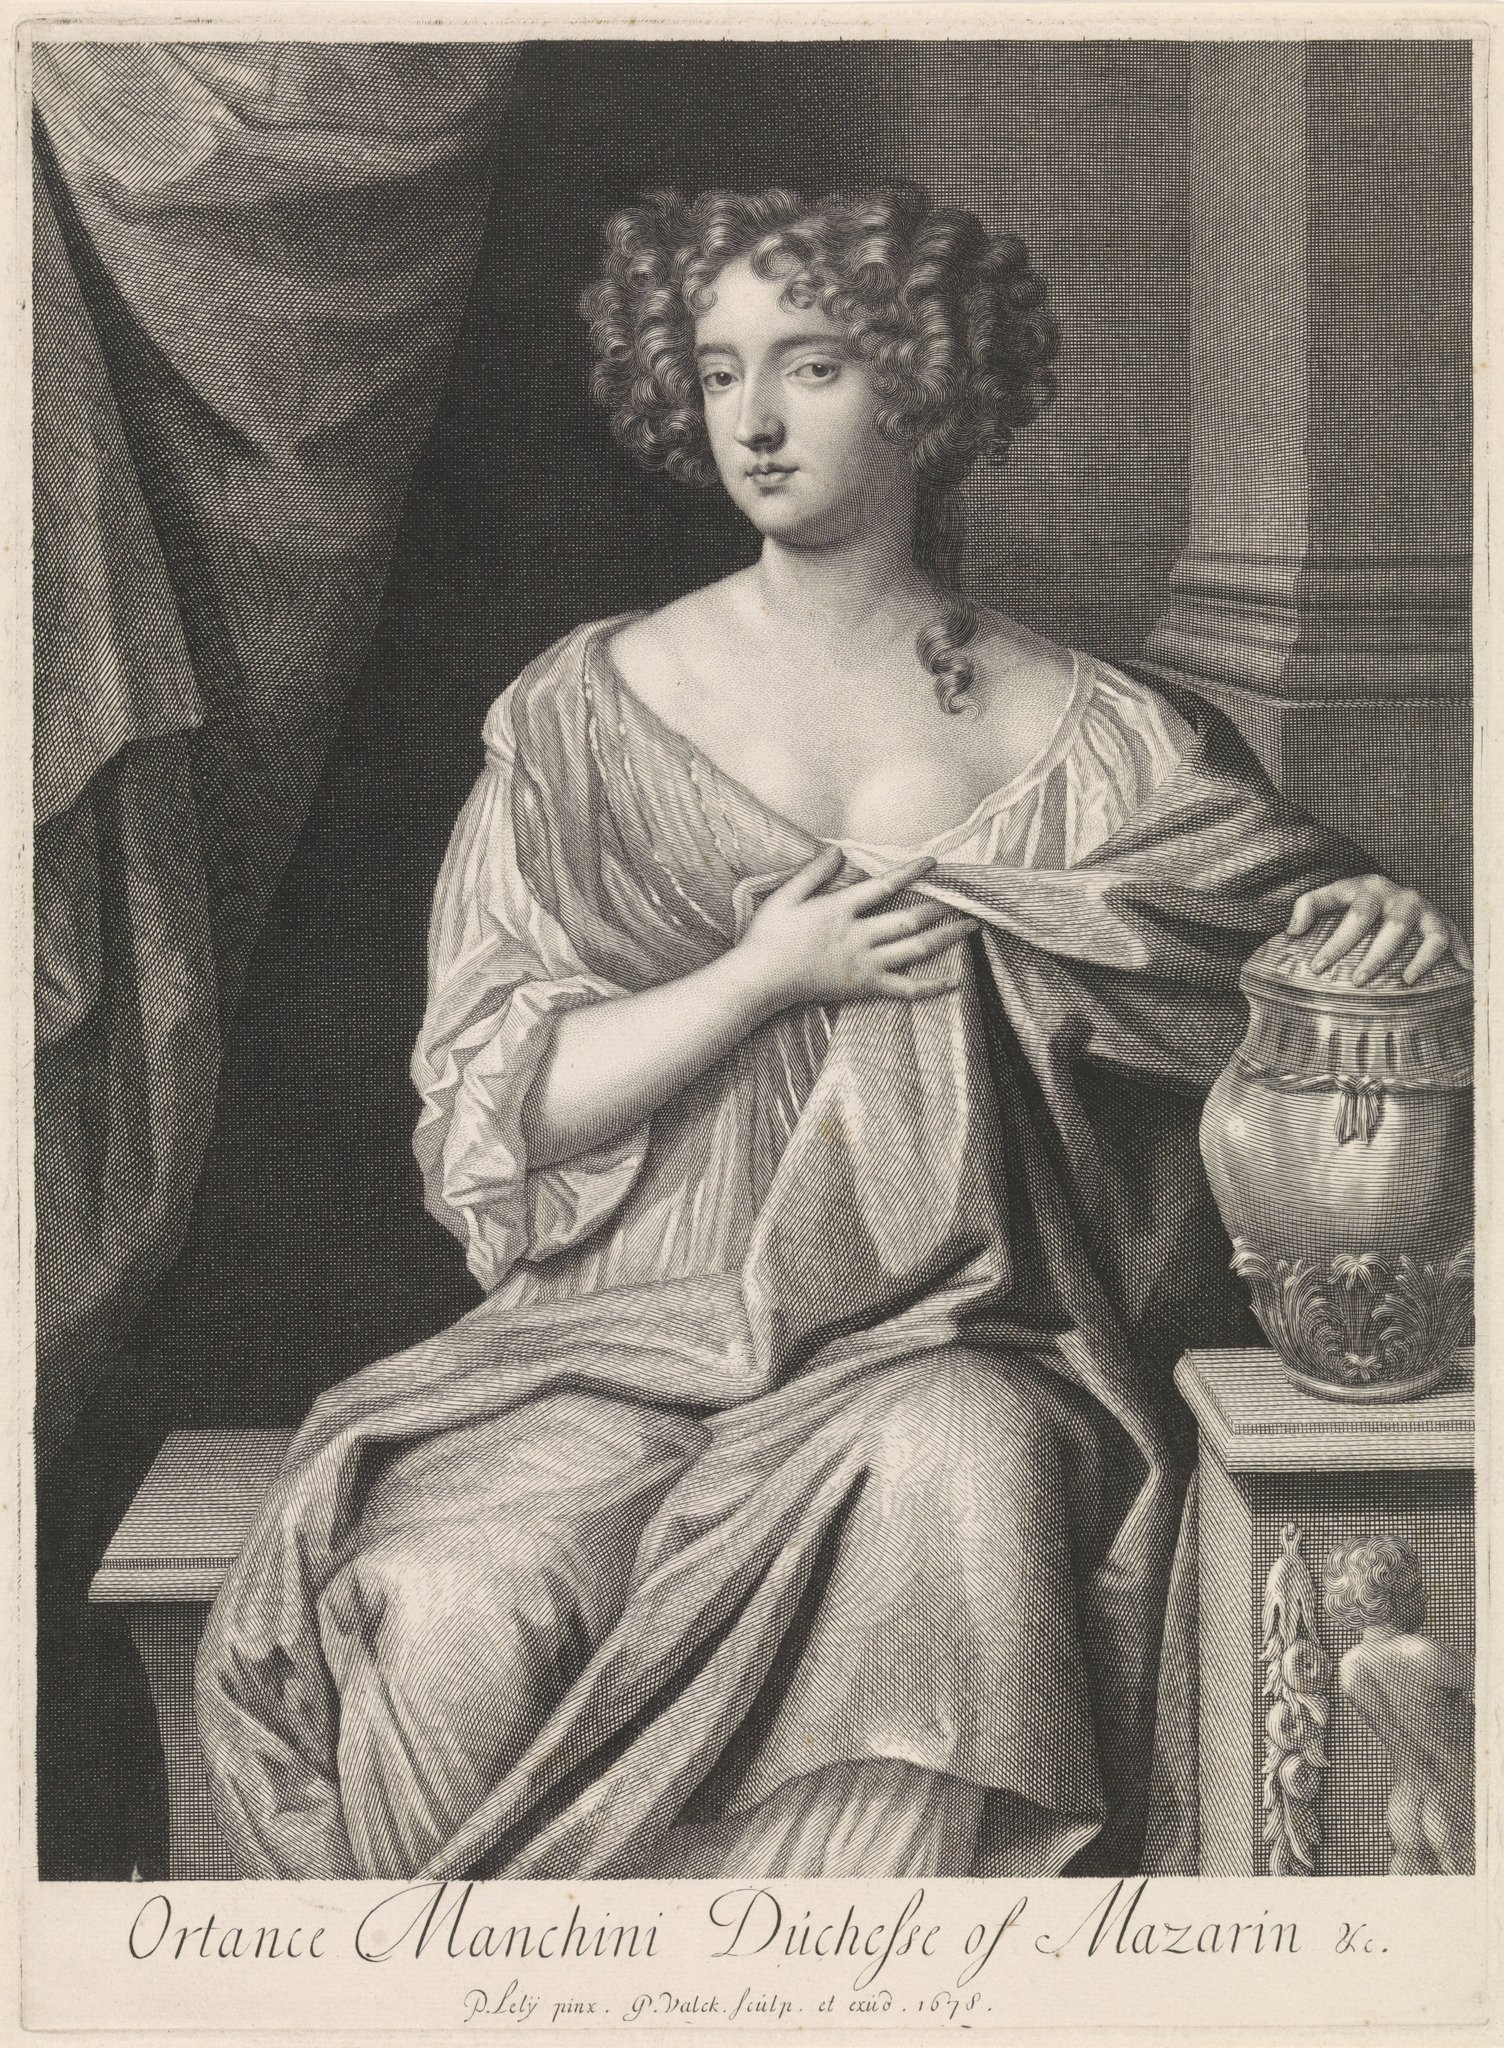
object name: print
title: Portret van Hortense Mancini, hertogin van Mazarin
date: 1678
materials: paper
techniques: engraving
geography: amsterdam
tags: rome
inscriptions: collector's mark: Lugt 2228